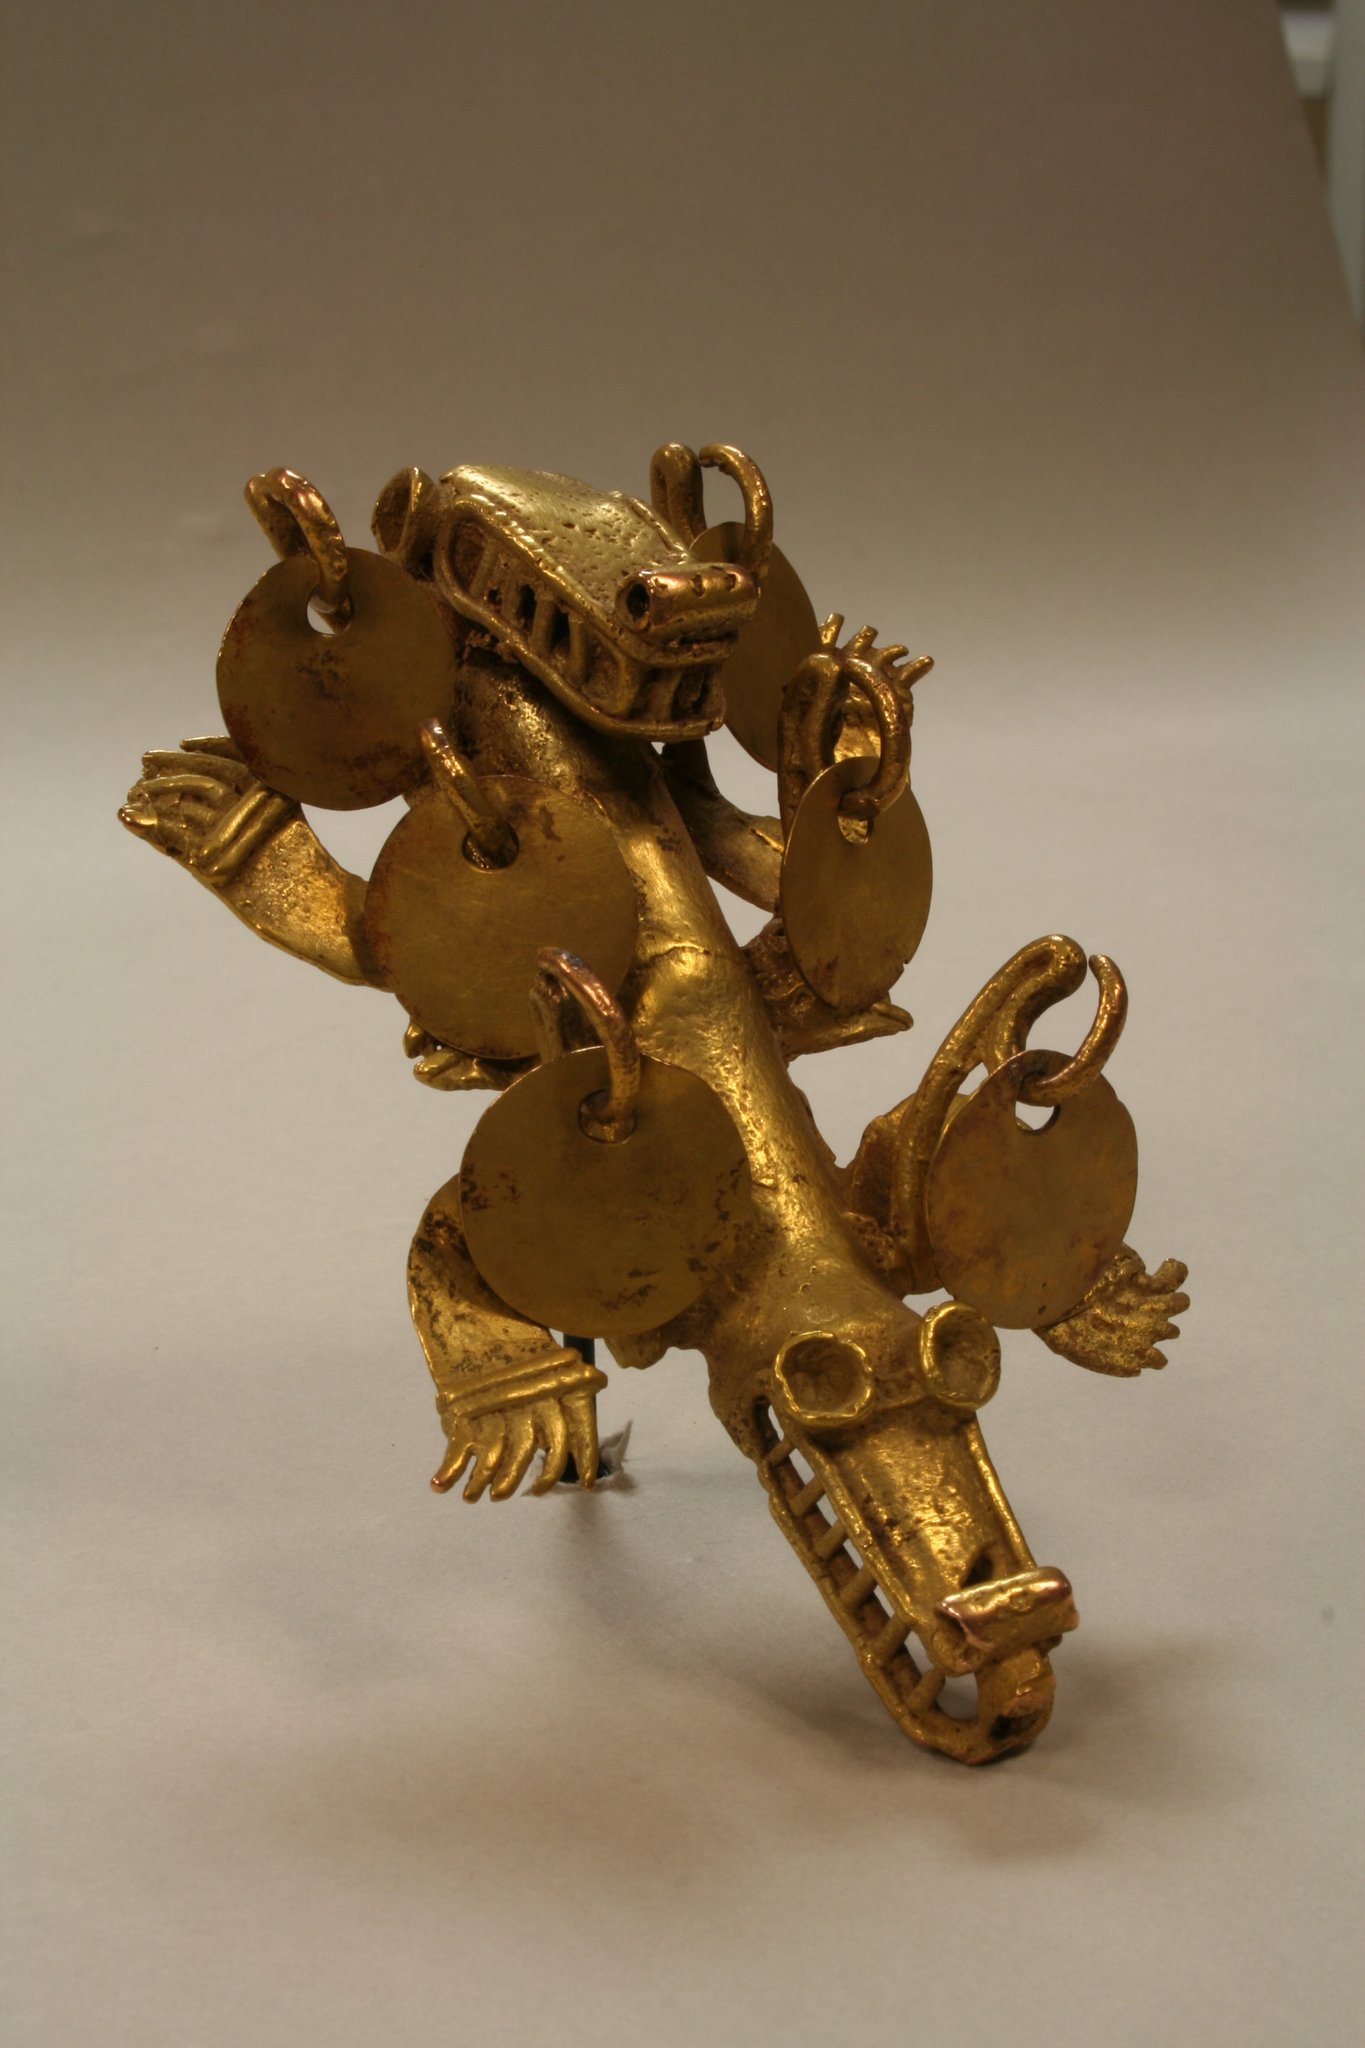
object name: pendant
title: Double Crocodile Pendant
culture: diquís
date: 1201-1600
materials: gold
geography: costa rica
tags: crocodiles